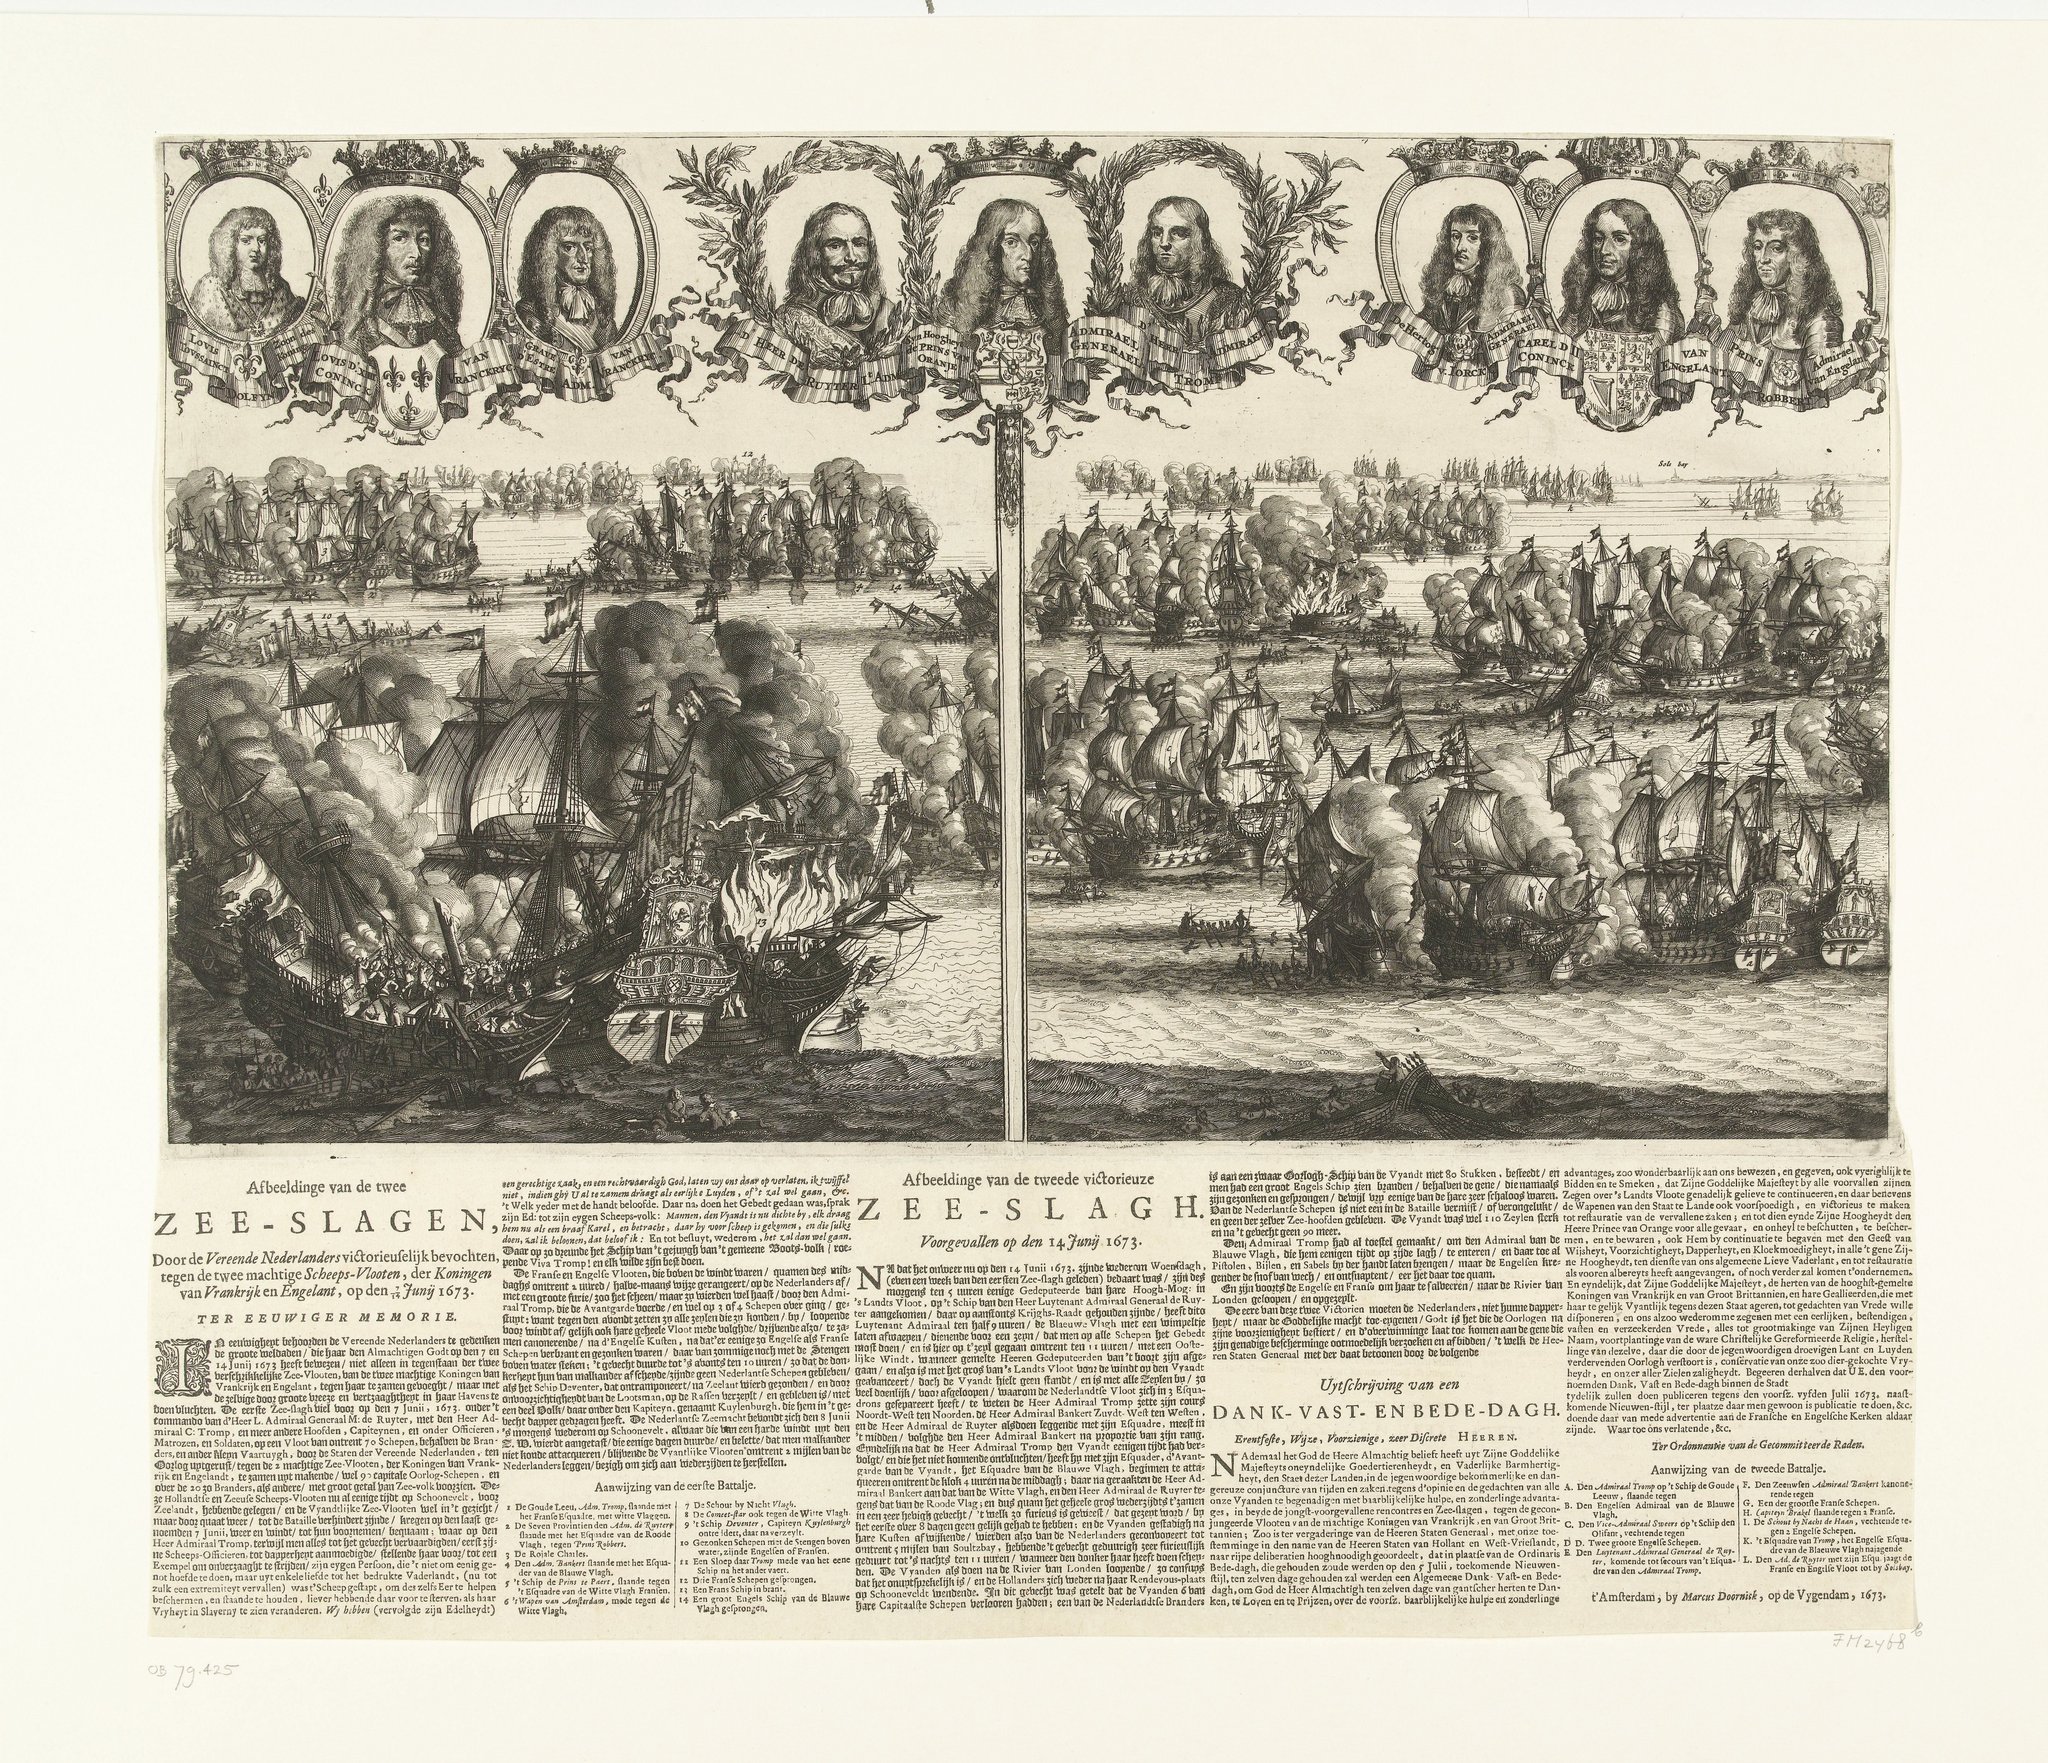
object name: print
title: Afbeeldinge van de twee Zee-Slagen, Door de Vereende Nederlanders victorieuselijk bevochten, tegen de twee machtige Scheeps-Vlooten, der Koningen van Vrankrijk en Engelant, op den 7/14 Junij 1673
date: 1673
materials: paper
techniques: etching, letterpress printing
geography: northern netherlands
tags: prague, london, painter, print maker, draughtsman, prinz ruprecht, flushing, michiel adriaenszoon de ruyter, rotterdam, amsterdam, cornelis tromp, jacobus ii (koning van engeland en schotland), the hague, william iii (prince of orange and king of england, scotland, and ireland), lodewijk xiv (koning van frankrijk), karel ii (koning van engeland), dauphin van frankrijk lodewijk, battle (+ naval force), first battle of schooneveld, second battle of schooneveld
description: De twee zeeslagen voor de Zeeuwse kust op de vlakte van Schoonevelt op 7 juni en 14 juni 1673. De slagen tussen de vloot van de Republiek onder Michiel Adriaenszoon de Ruyter en de gecombineerde Engels-Franse vloot onder Prins Rupert en graaf Jean d'Estrées. Bovenaan negen medaillons met portretten van de Franse koning Lodewijk XIV, de dauphin en admiraal d'Estrées, de Nederlandse prins Willem en admiralen Michiel Adriaenszoon de Ruyter en Cornelis Tromp en de Engelse koning Karel II en admiralen hertog van York (de latere koning Jacobus II) en prins Ruprecht. De voorstelling met een verticale balk in tweeën gedeeld. Onder de voorstelling een beschrijving van de gebeurtenissen in 5 kolommen in het Nederlands.